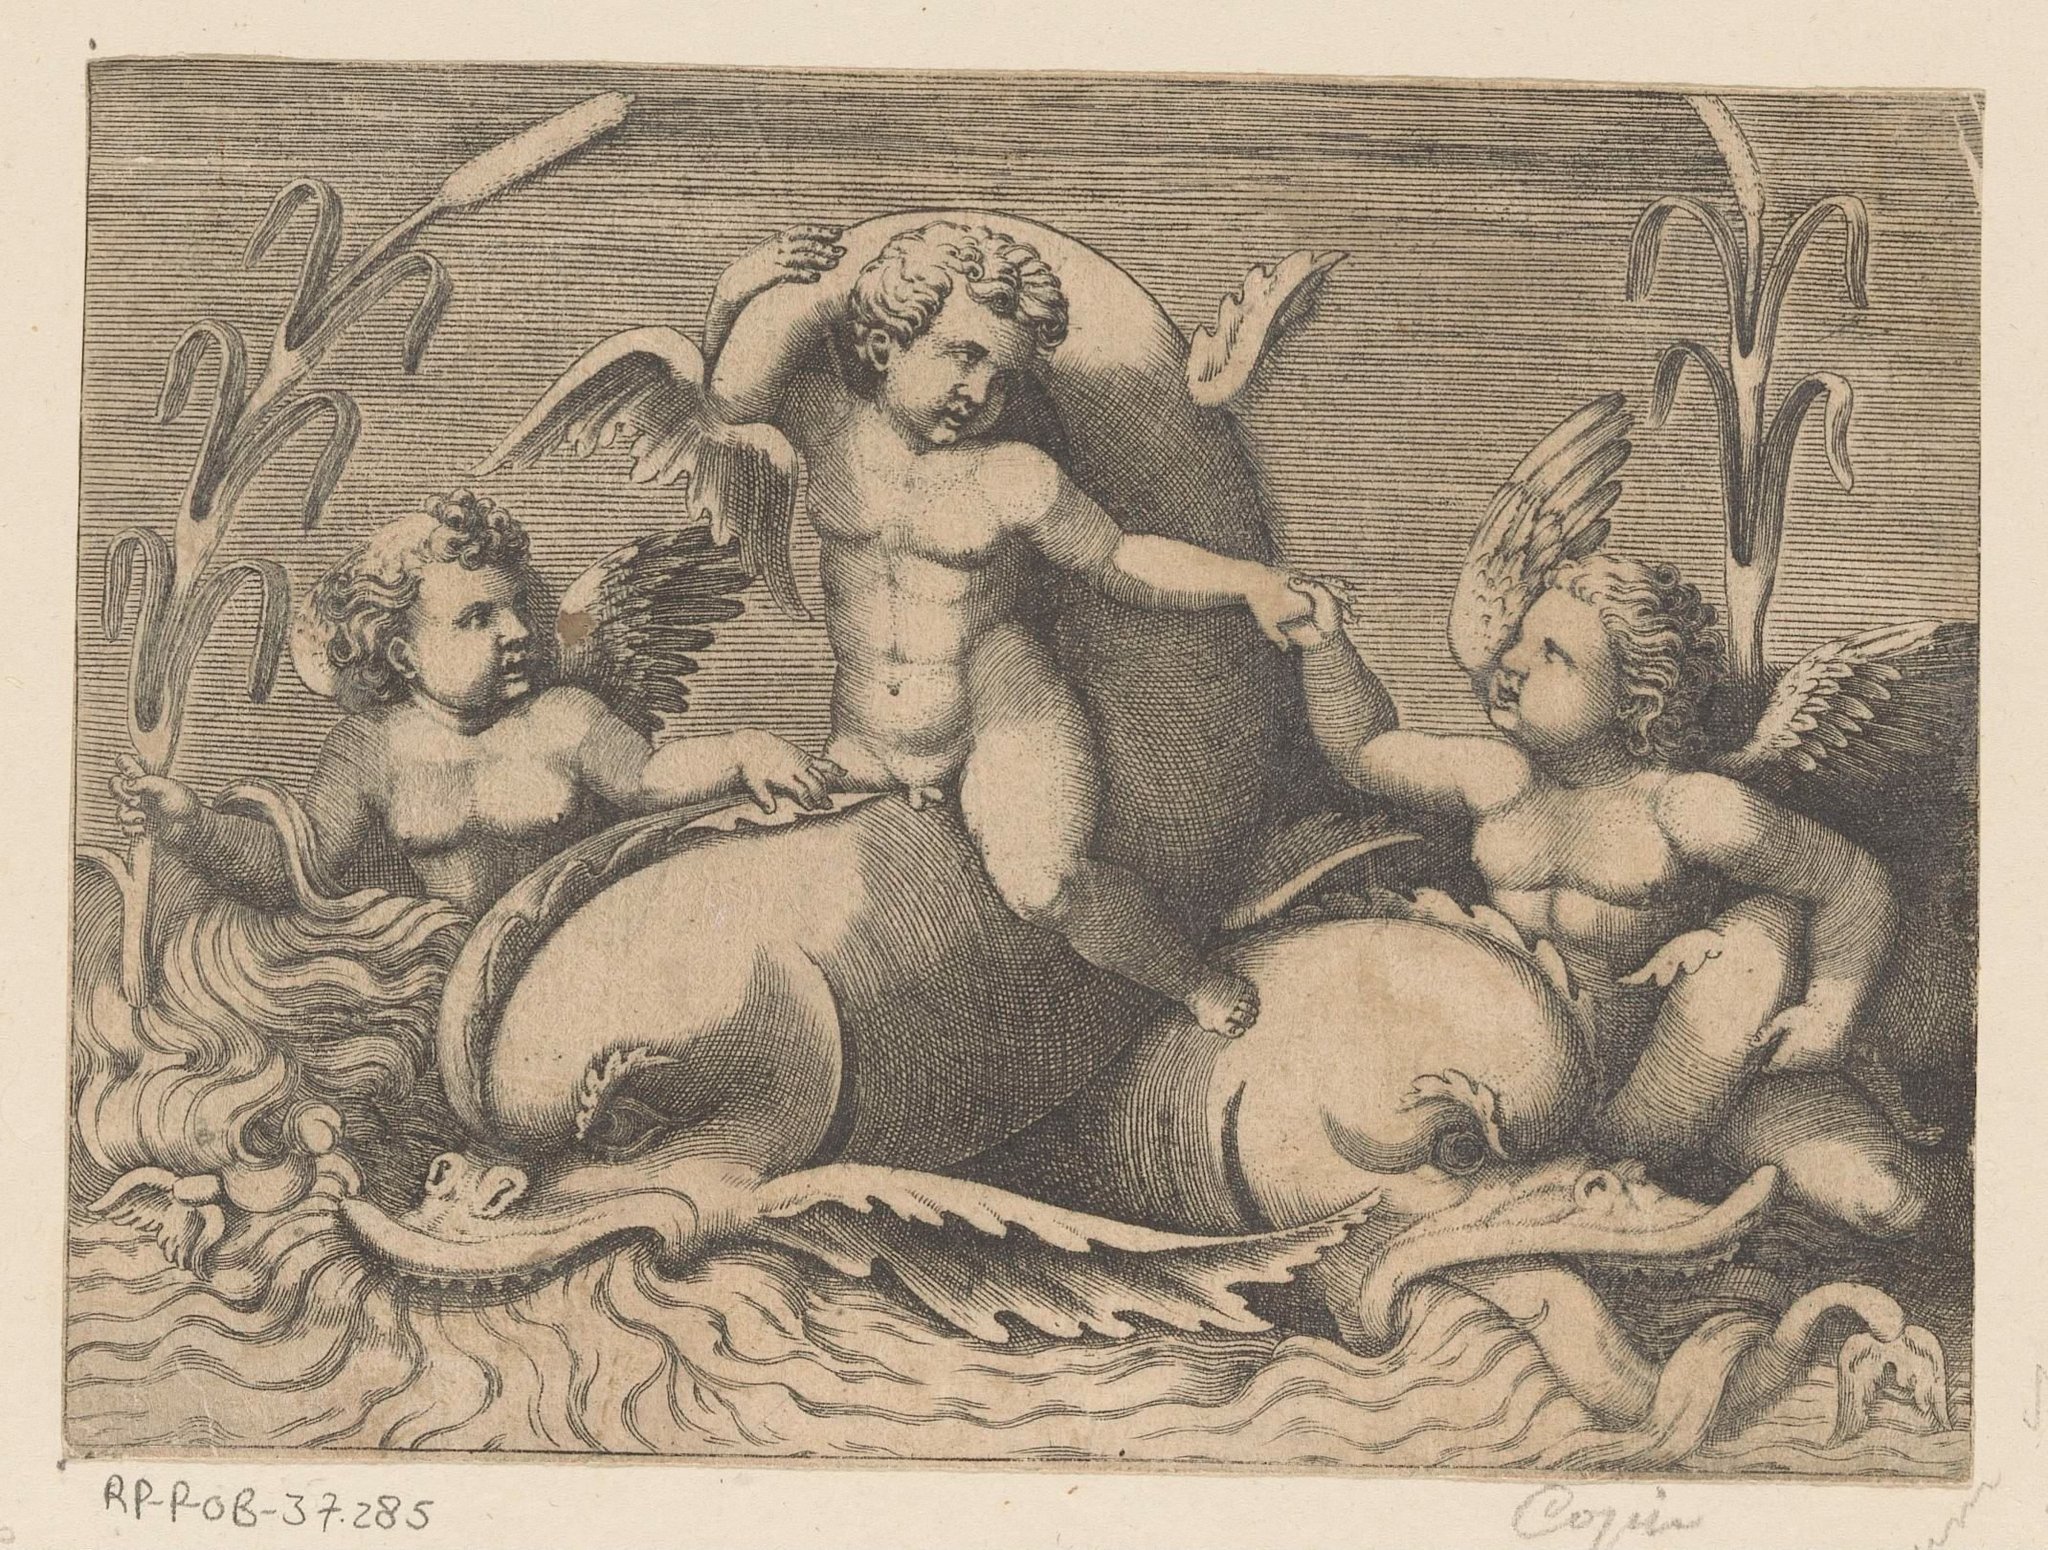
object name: print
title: Drie putti met dolfijnen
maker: Anonymous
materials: paper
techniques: engraving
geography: italy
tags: swimming mammals: dolphin, cupids: 'amores', 'amoretti', 'putti'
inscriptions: collector's mark: Lugt 240